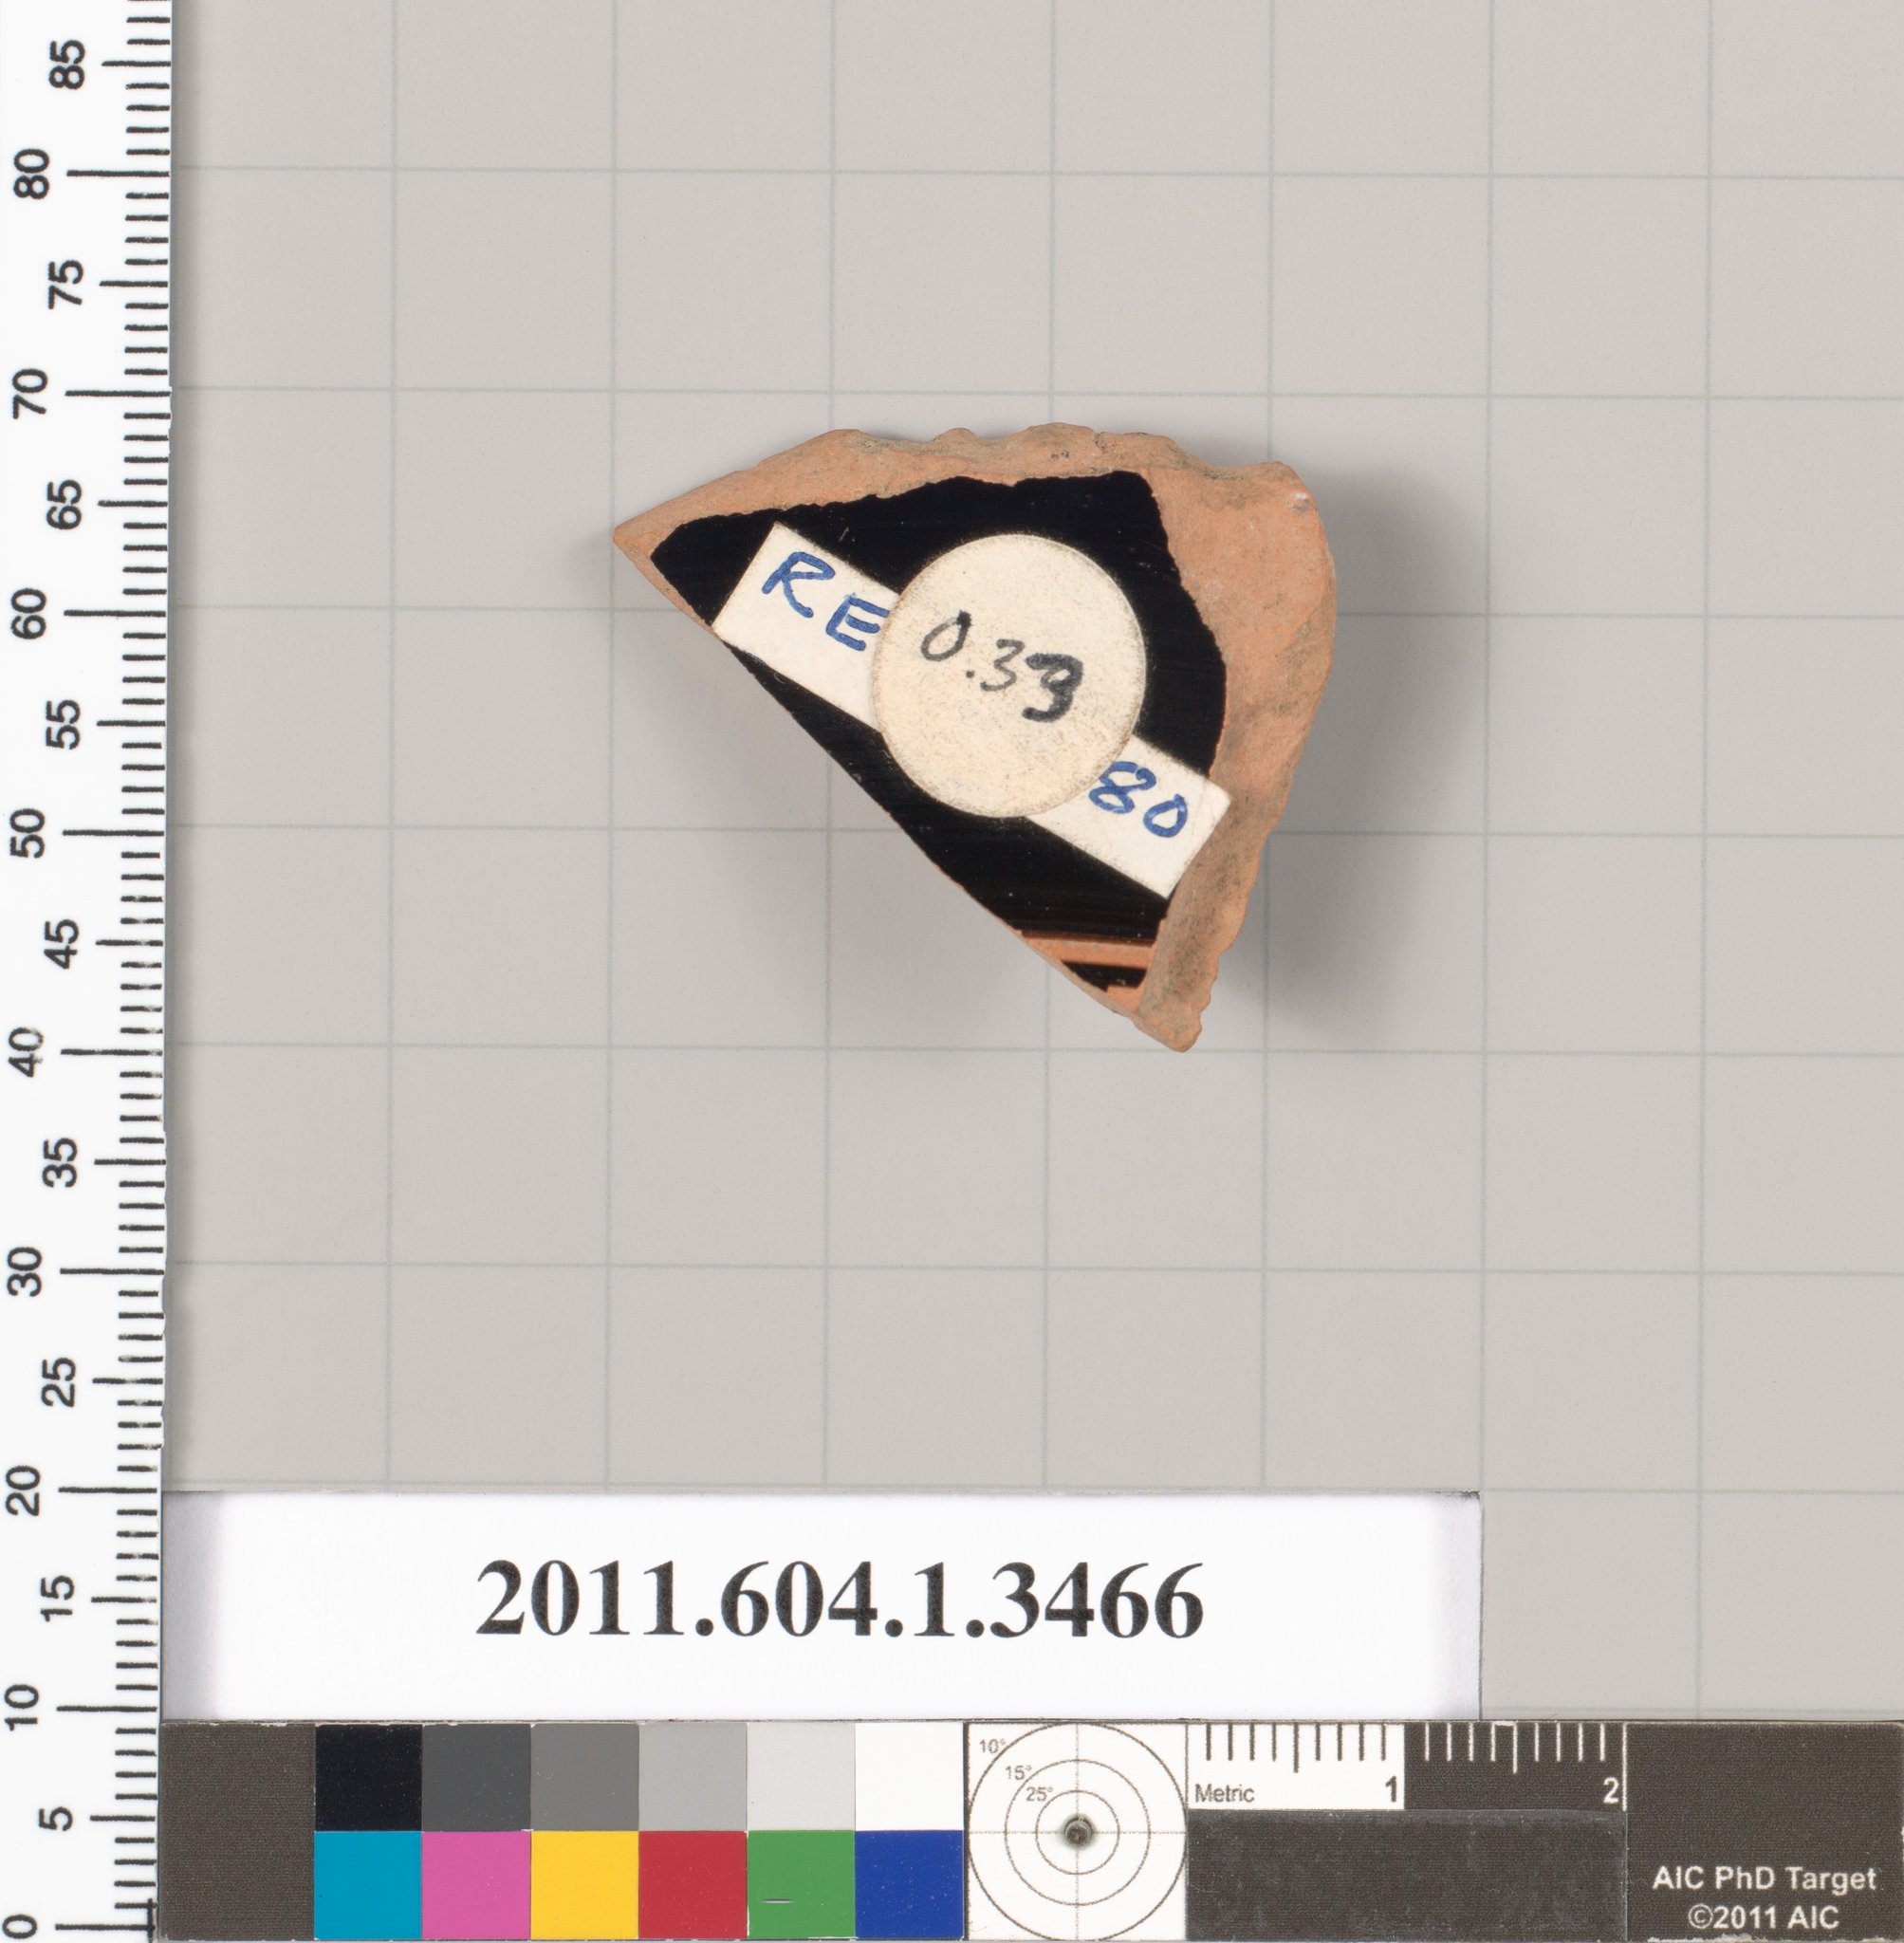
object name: kylix fragment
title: Terracotta fragment of a kylix (drinking cup)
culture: greek, attic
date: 600-401 BCE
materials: terracotta